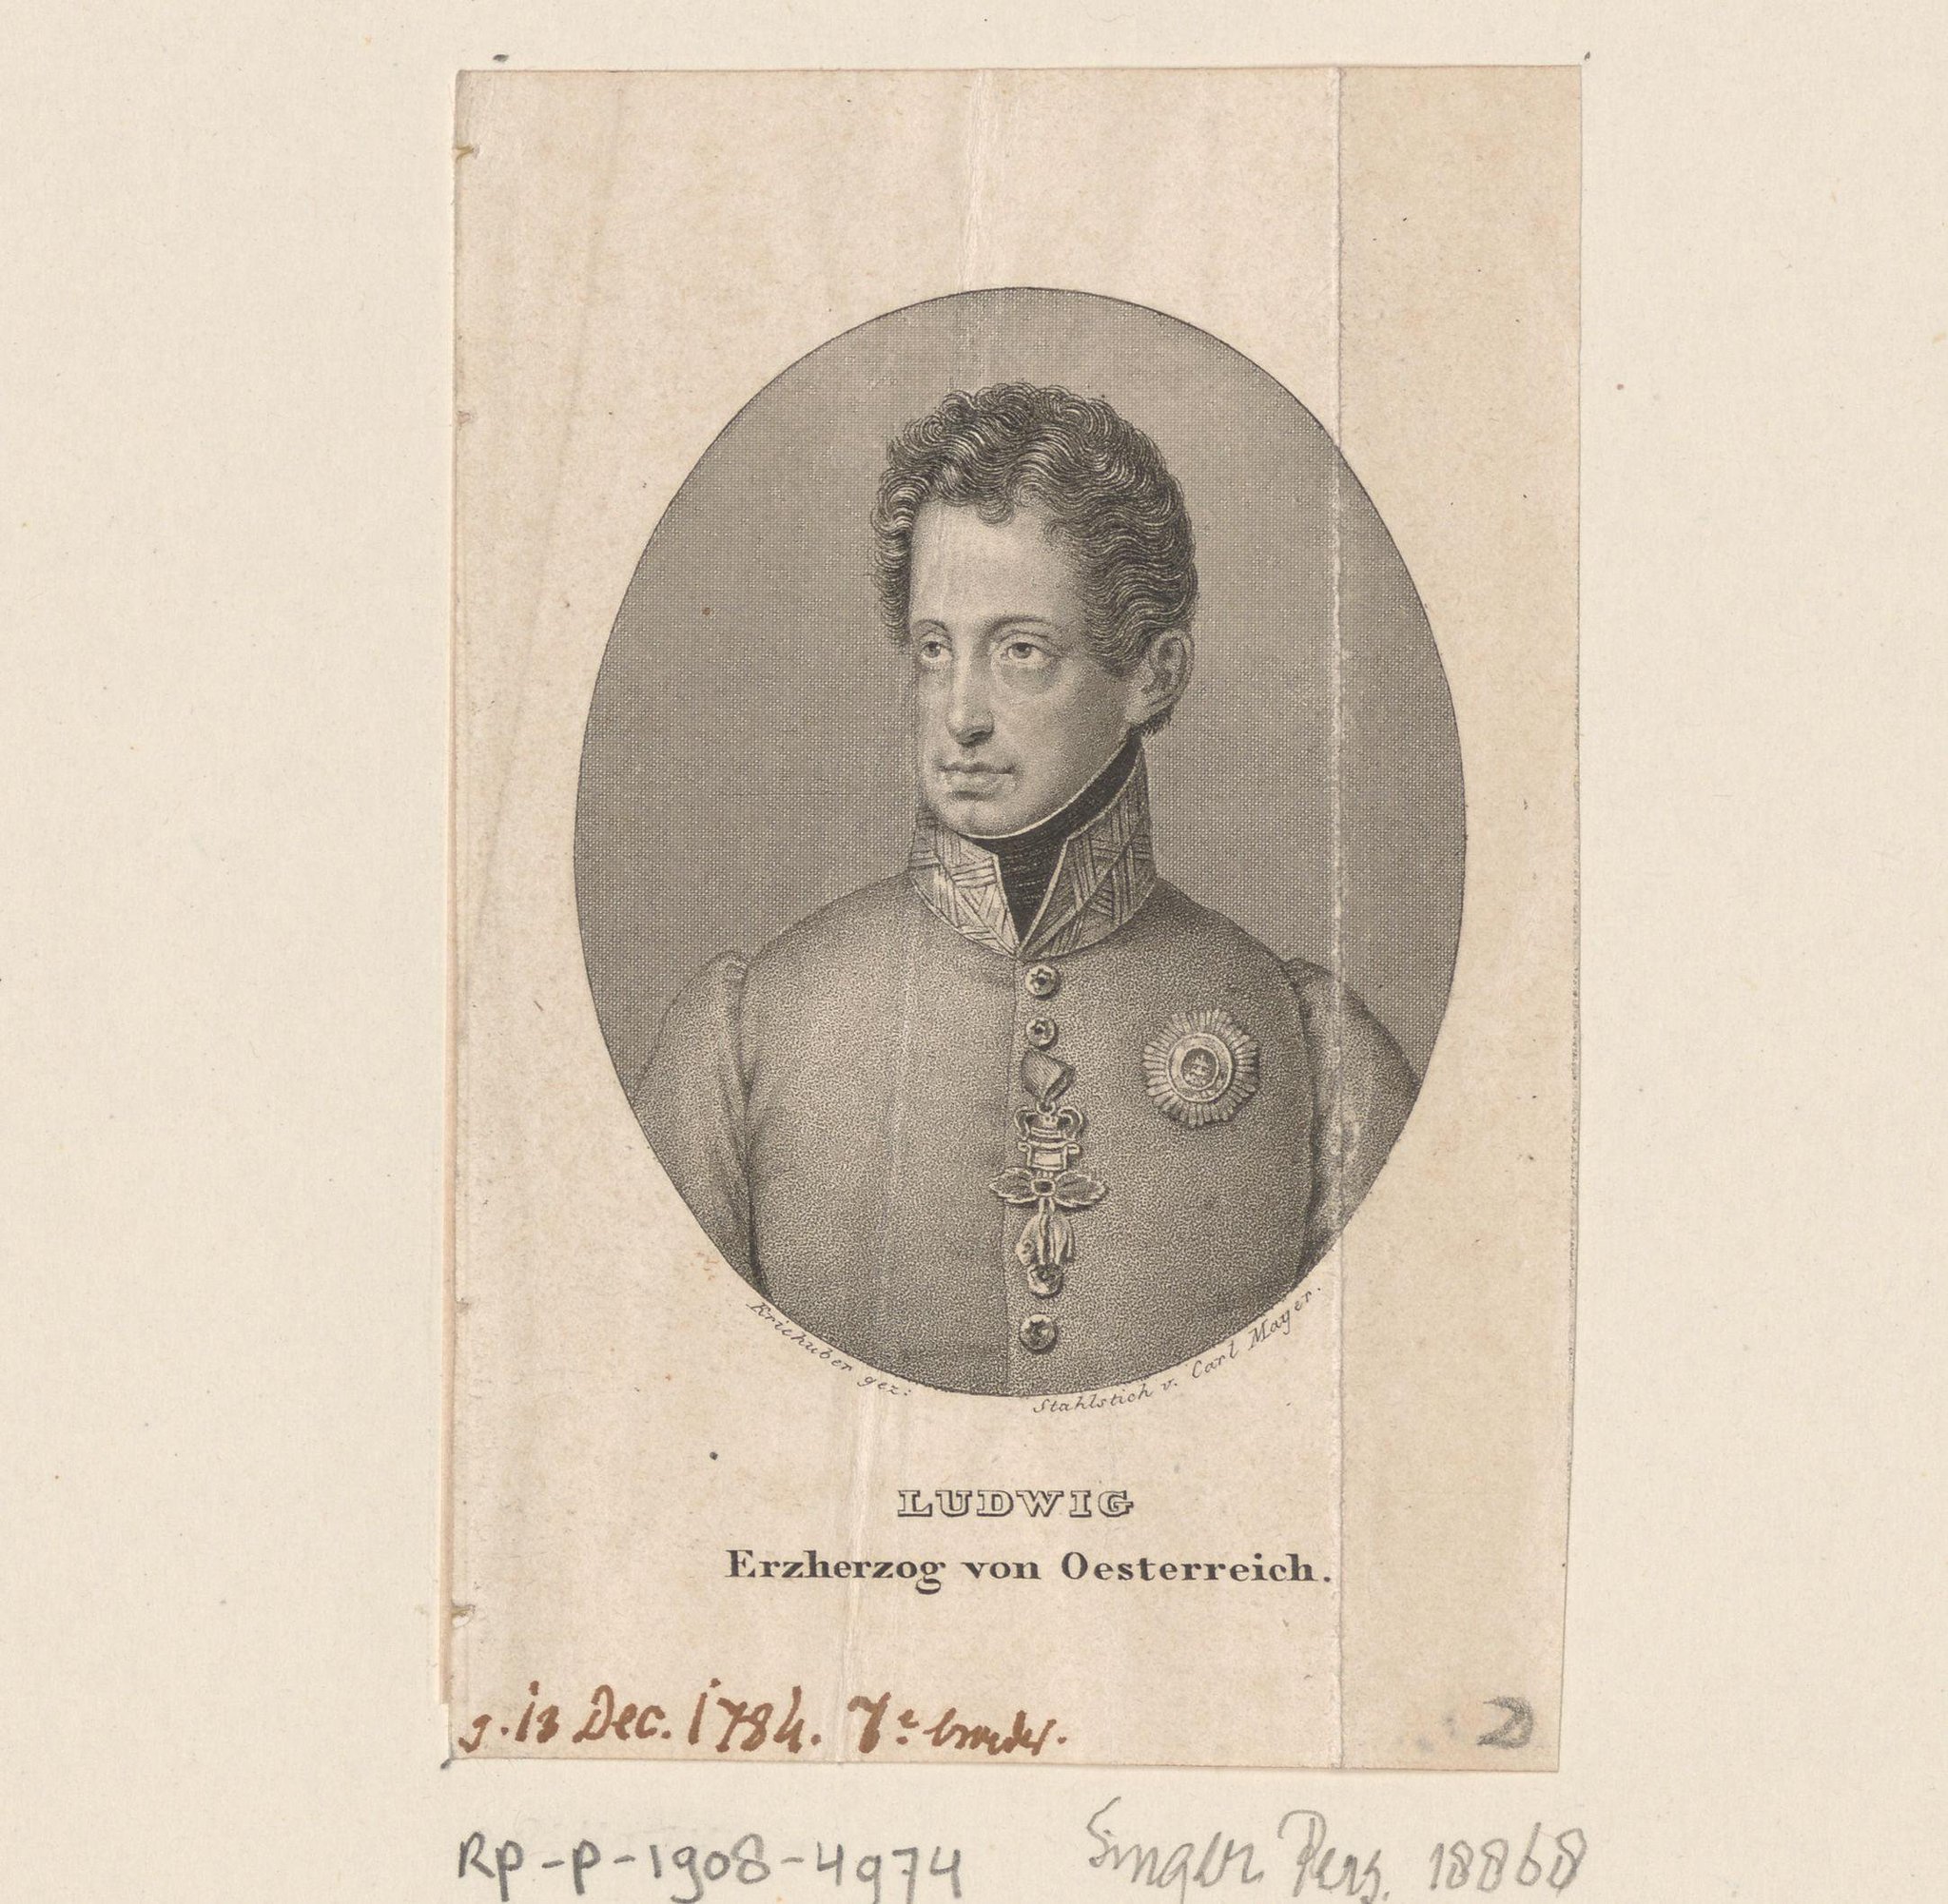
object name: print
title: Portret van Lodewijk van Oostenrijk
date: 1837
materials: paper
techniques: engraving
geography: nuremberg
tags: historical persons, (military) uniforms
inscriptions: collector's mark: Lugt 2228, inscription: ‘1837’, inscription: ‘g. 13 Dec 1784 7e broeder [?]’